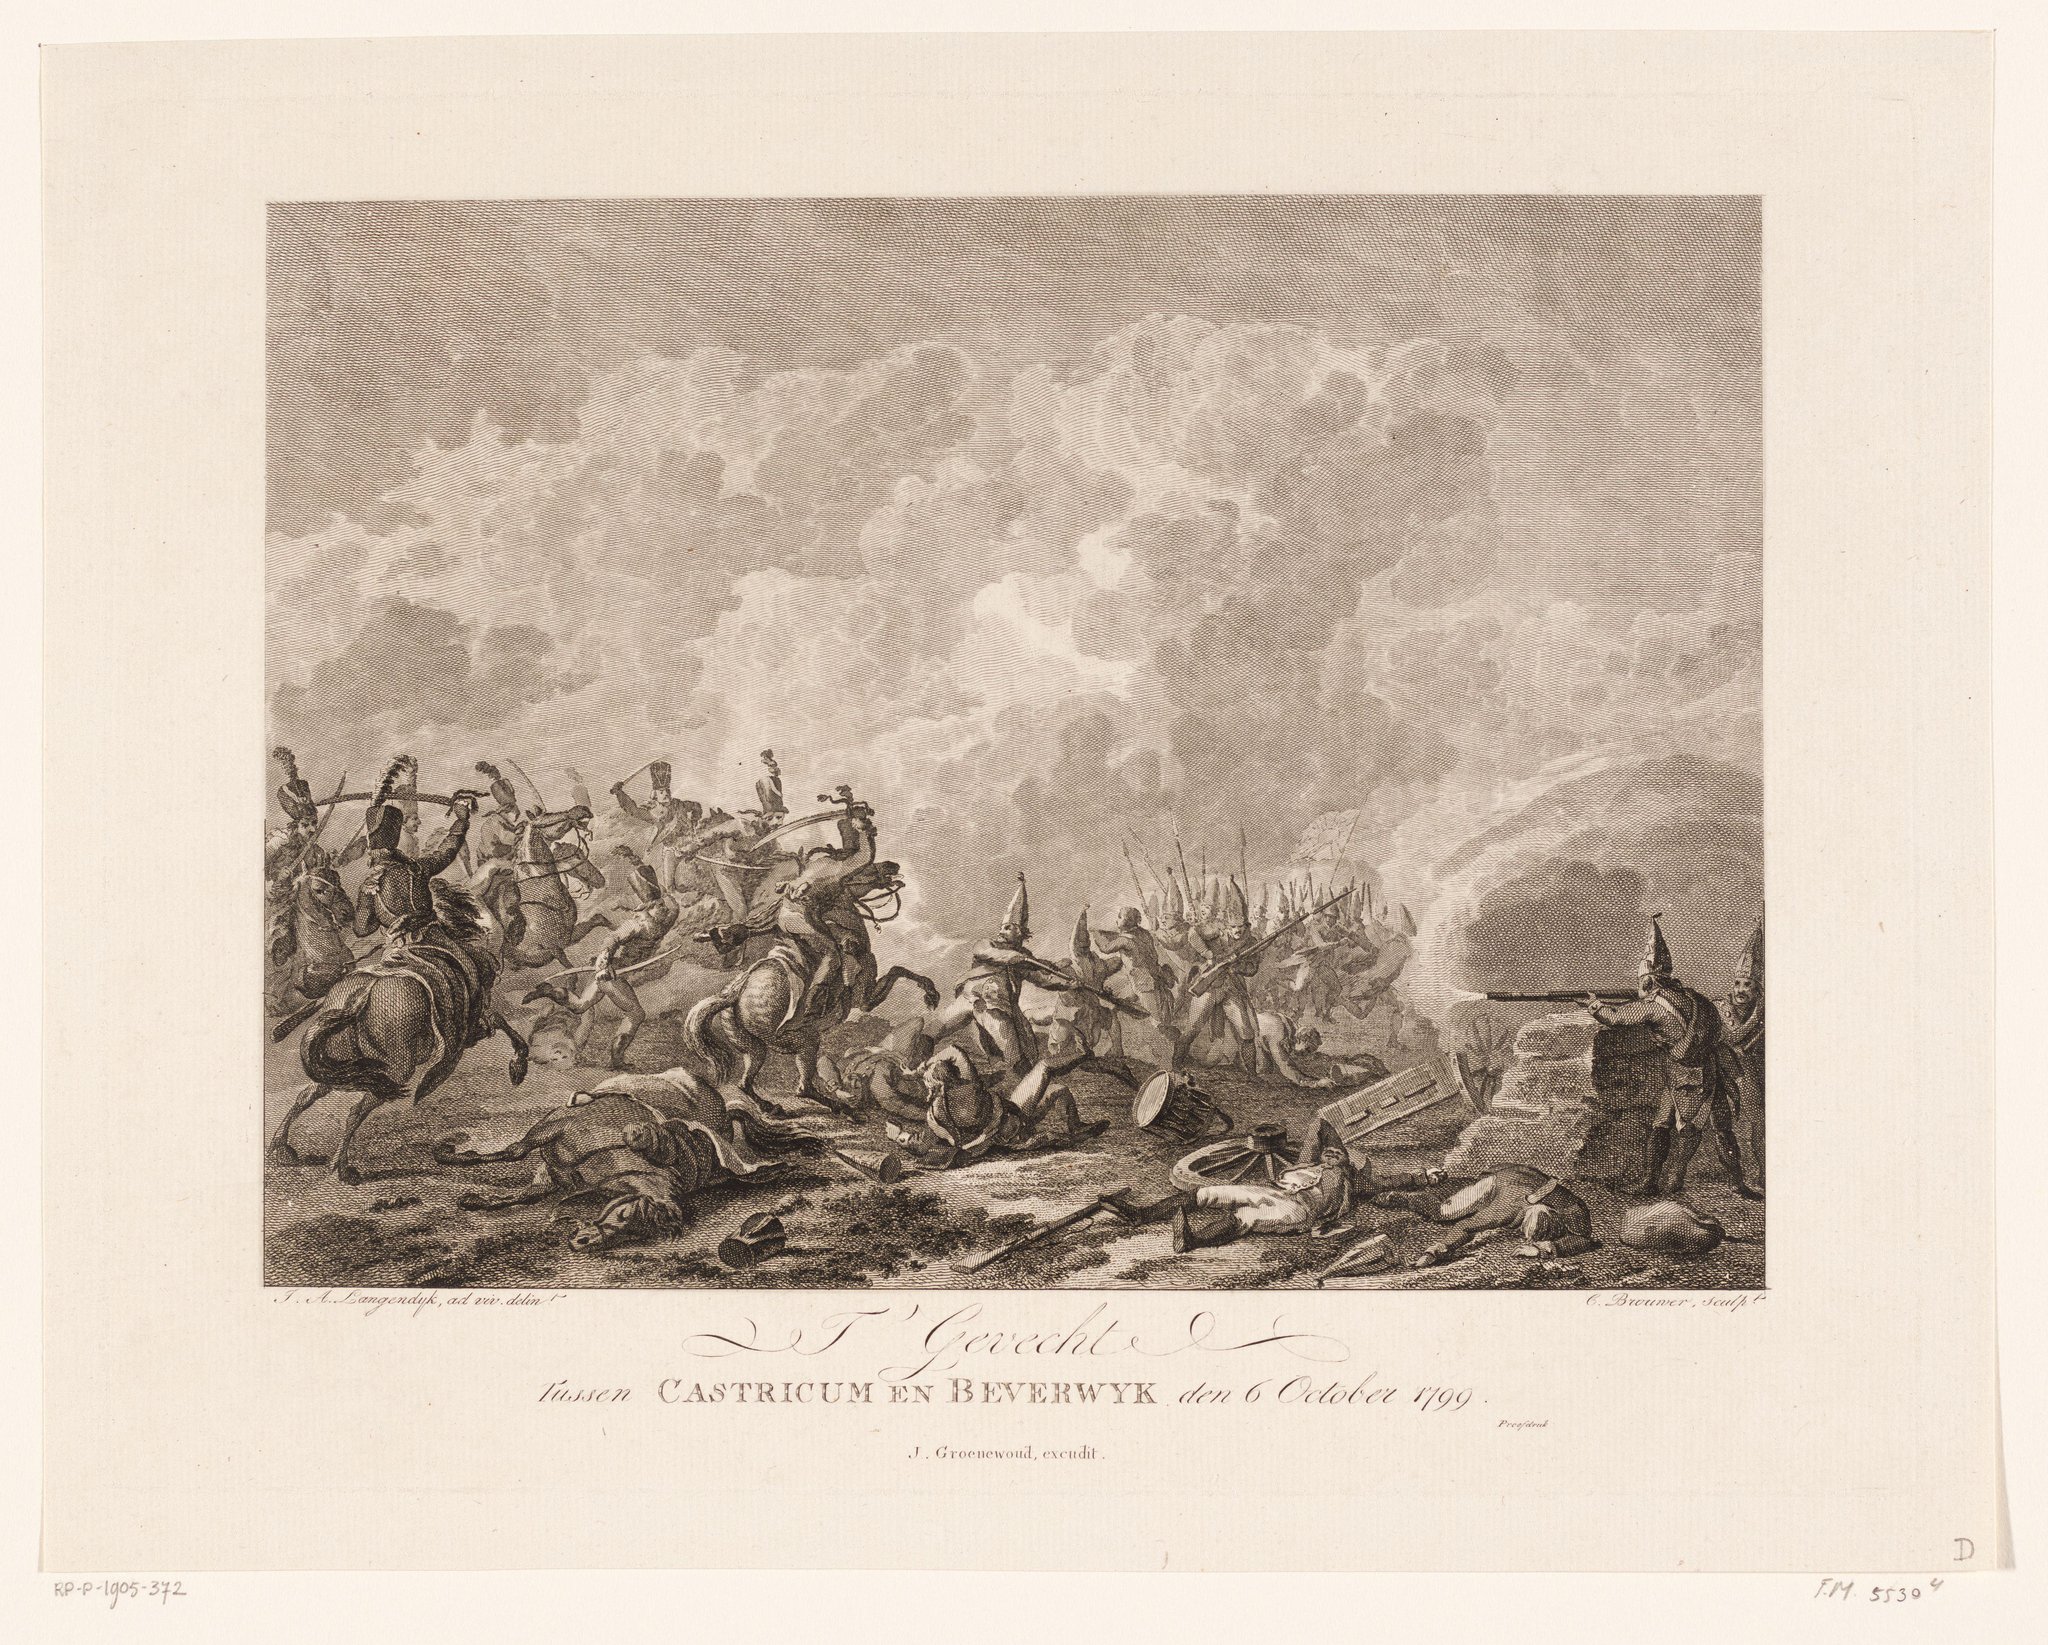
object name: print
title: Het Frans-Bataafse leger verjaagt de Russen en Engelsen bij Castricum en Beverwijk op 6 oktober 1799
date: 1799-1803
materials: paper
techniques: etching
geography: netherlands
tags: warfare; military affairs (+ during the battle)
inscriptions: collector's mark: Lugt 2228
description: Prent naar tekening van Jan Anthonie Langendijk. Prent uit serie van vier prenten met de Oorlog van het Frans-Bataafse leger tegen de Russen en Engelsen in 1799.